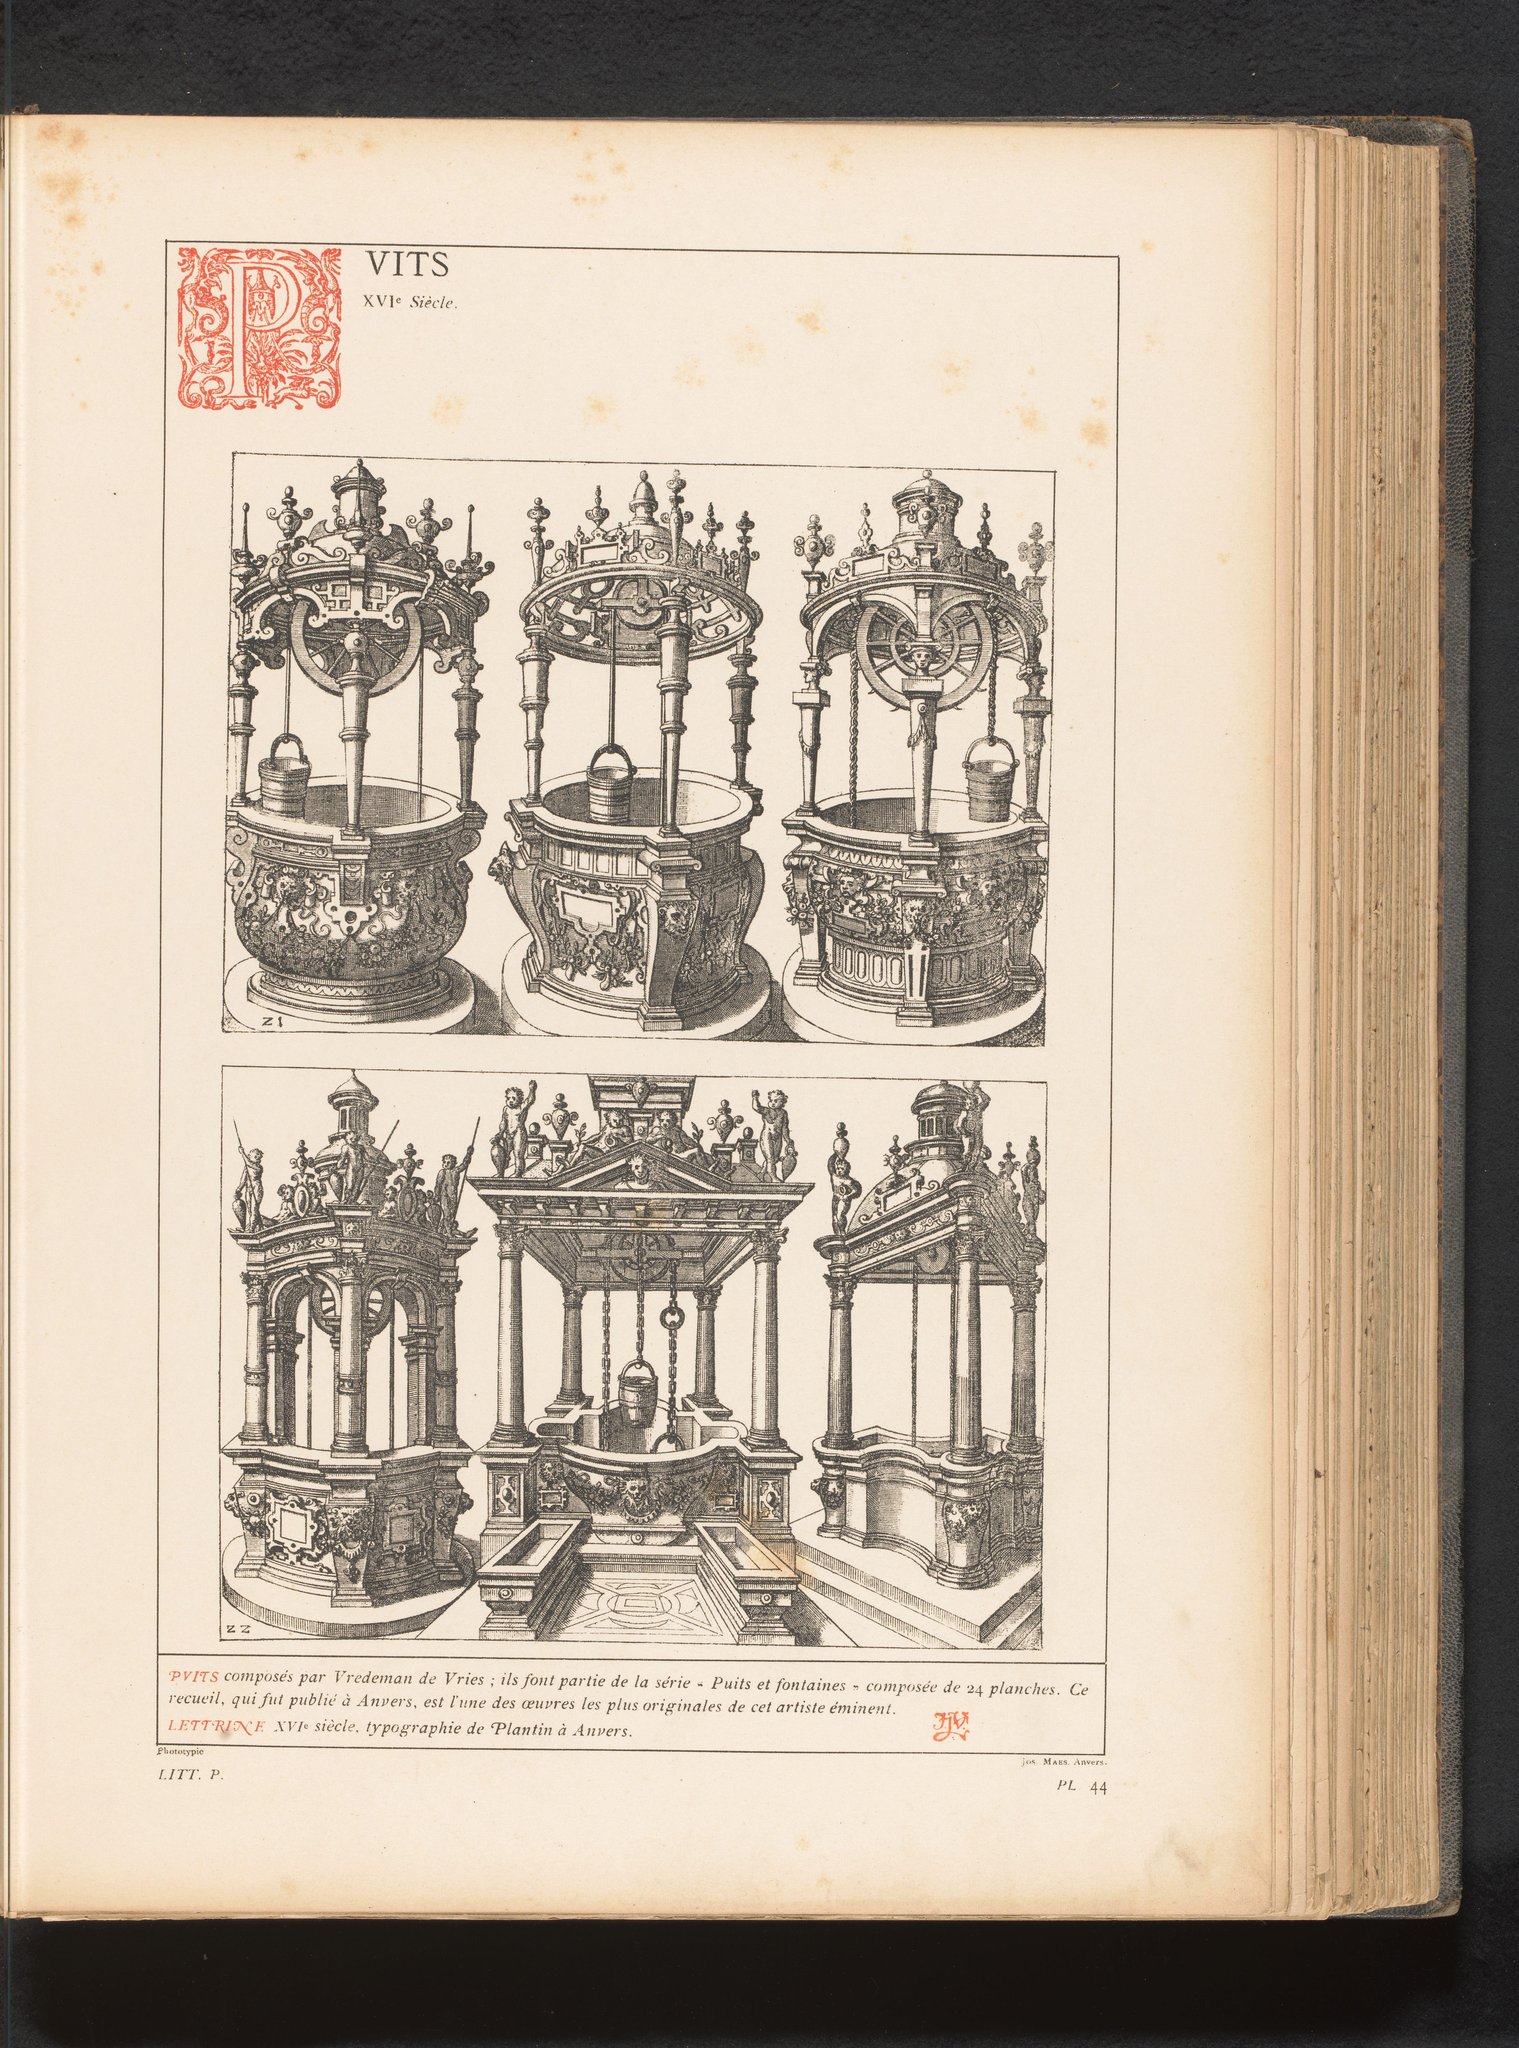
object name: page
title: Reproductie van een prent van gedecoreerde waterputten naar ontwerp van Hans Vredeman de Vries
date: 1876-1881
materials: paper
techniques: photolithography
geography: amsterdam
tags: well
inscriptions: inscription: ‘LITT. P. - PL. 44.’, inscription: ‘PUITS composés par (...)’, monogram: ‘JJvY’